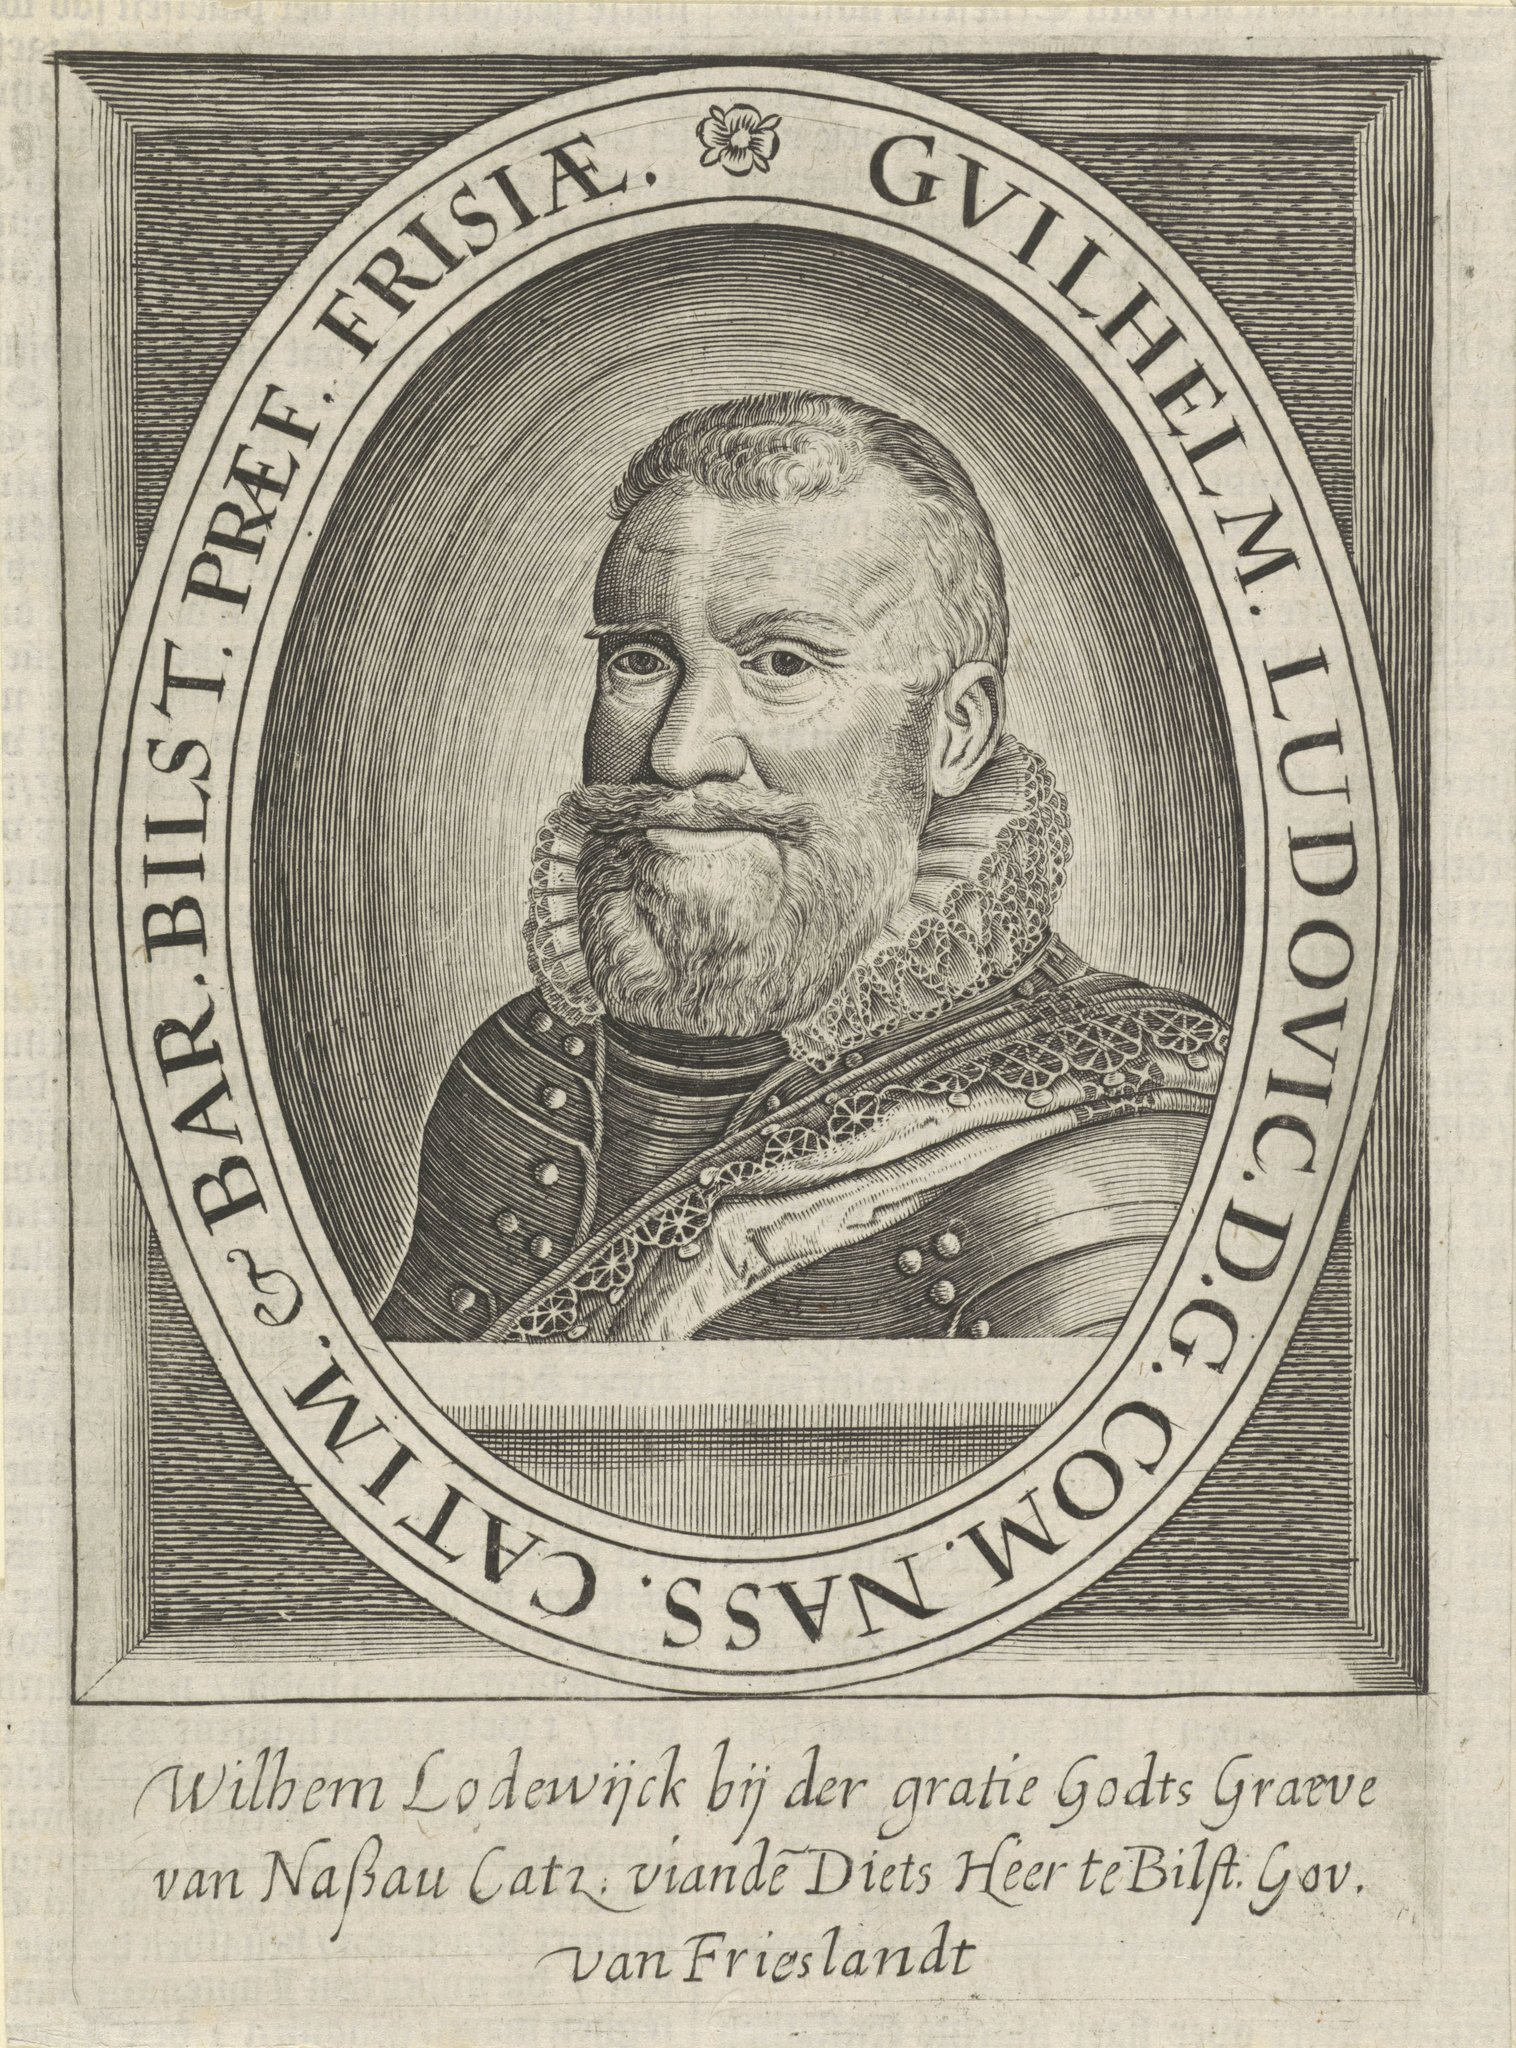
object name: print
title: Portret van Willem Lodewijk, graaf van Nassau-Dillenburg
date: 1663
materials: paper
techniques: engraving, etching, letterpress printing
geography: amsterdam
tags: willem lodewijk graaf van nassau-dillenburg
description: De hier vermelde titel verwijst naar de hoogst verkregen titel van de geportretteerde, niet per se naar de titel die de geportretteerde op deze voorstelling draagt. Prent uit: Meteren, Emanuel van. Historien der Nederlanden, en haar naburen oorlogen tot het iaar 1612. Amsterdam: Jan Jacobsz Schipper, 1663.